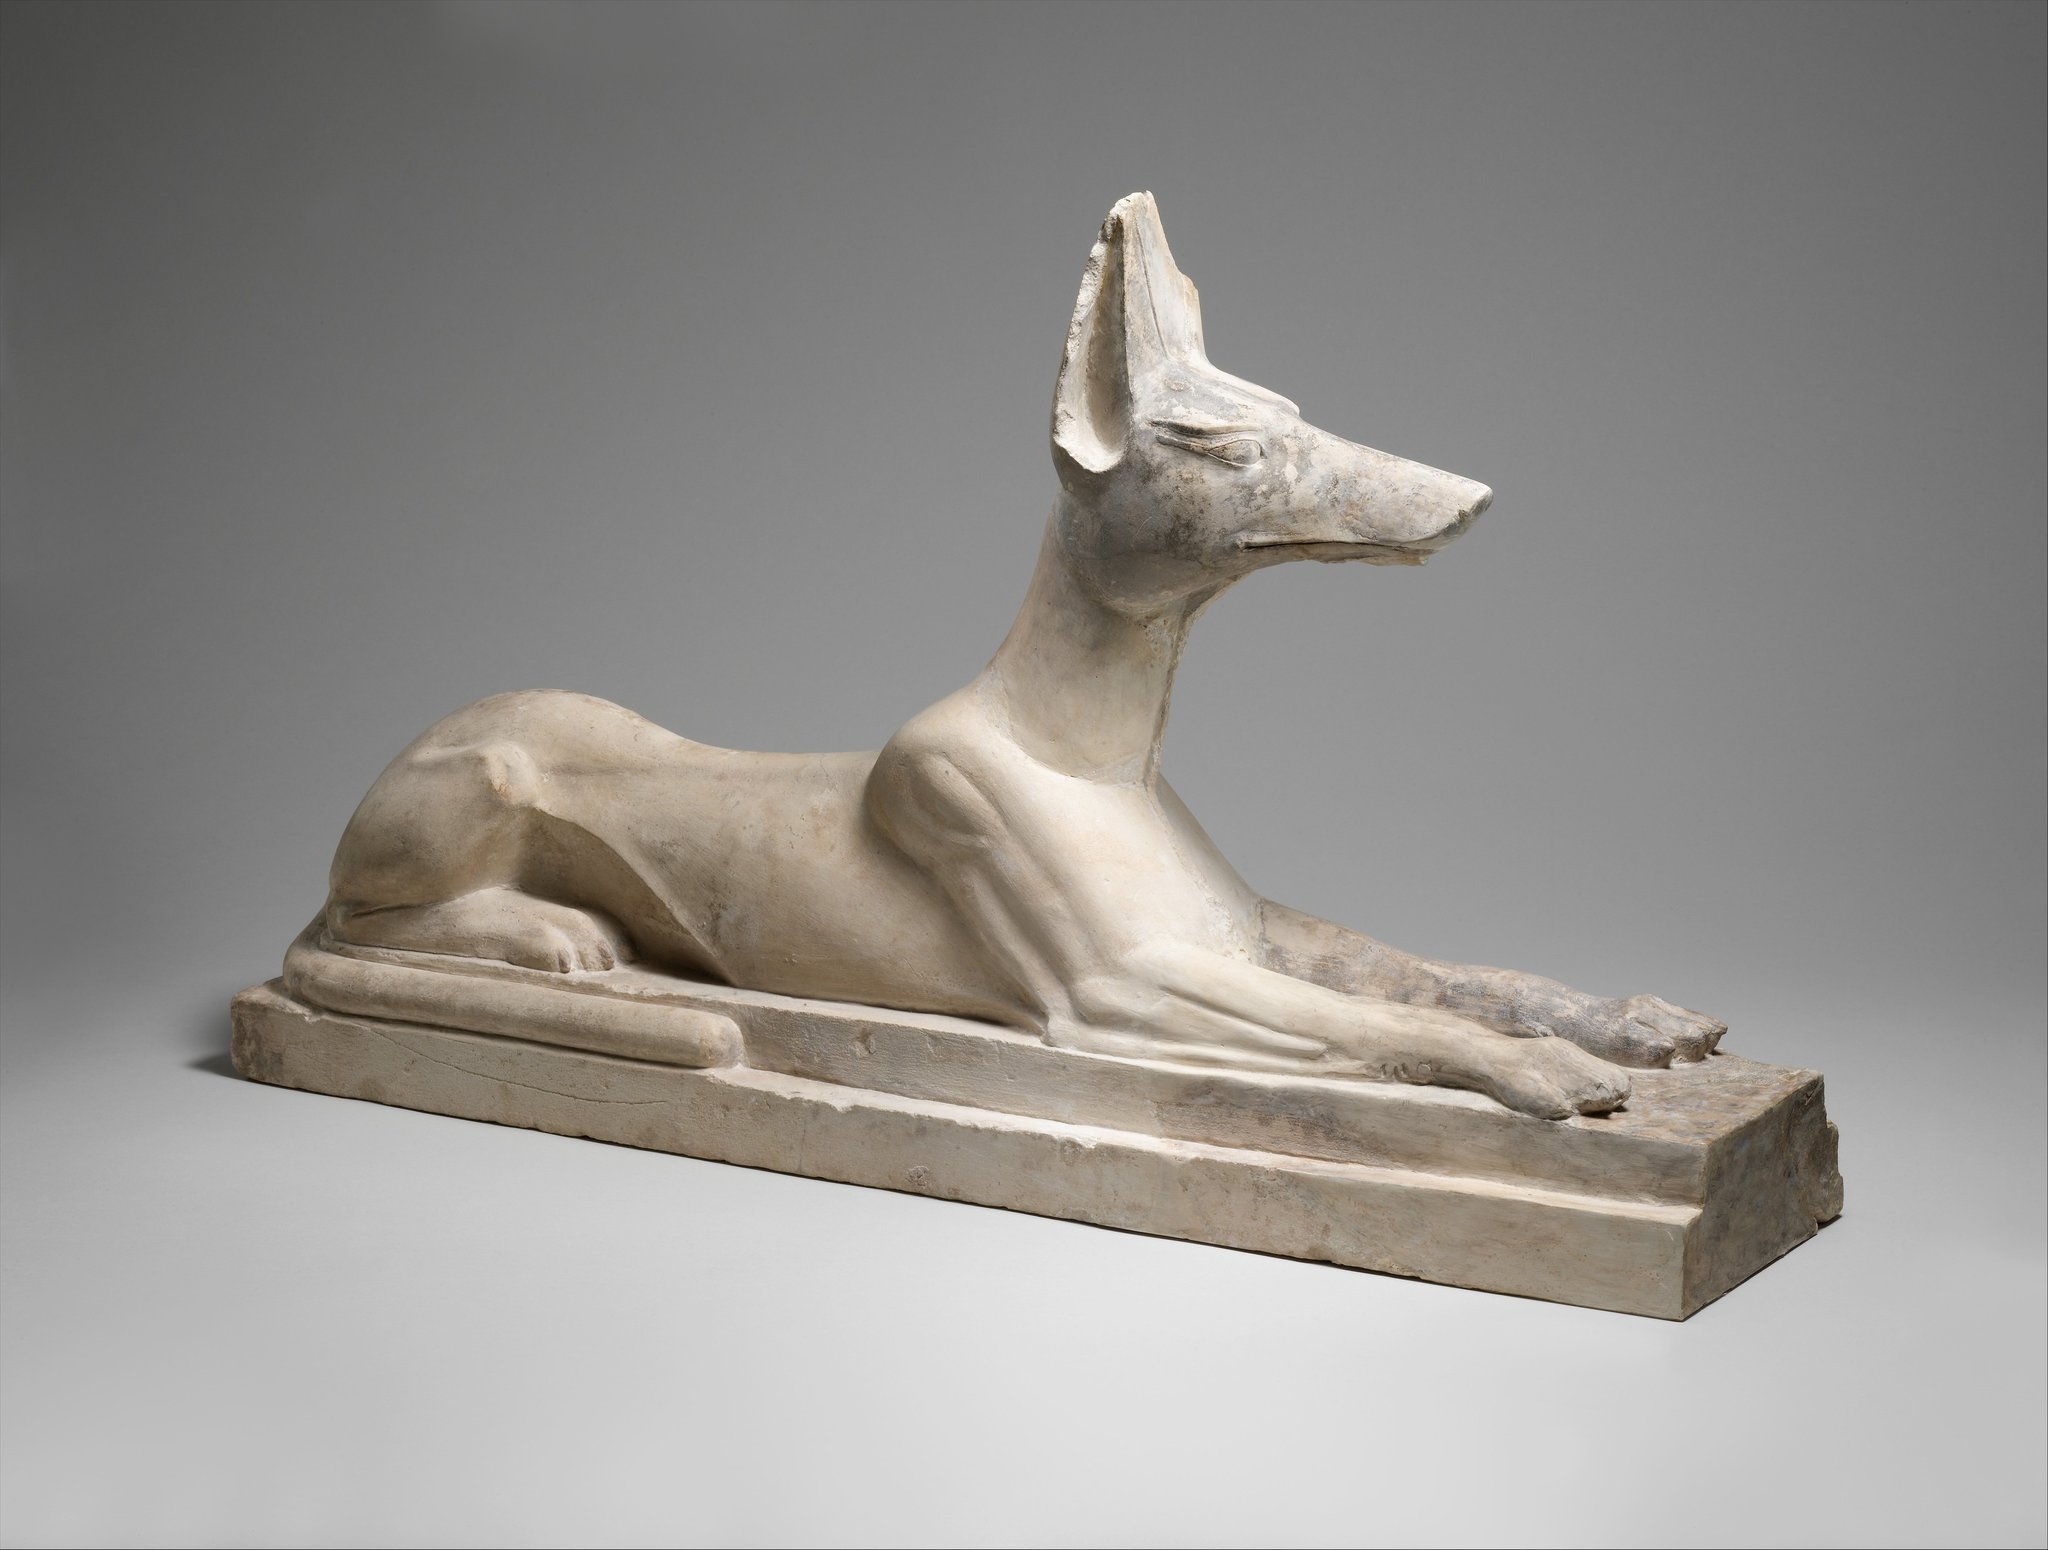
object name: statuette, anubis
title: Statue of Anubis as a recumbent canid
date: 343-330 BCE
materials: limestone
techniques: painting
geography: egypt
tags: anubis